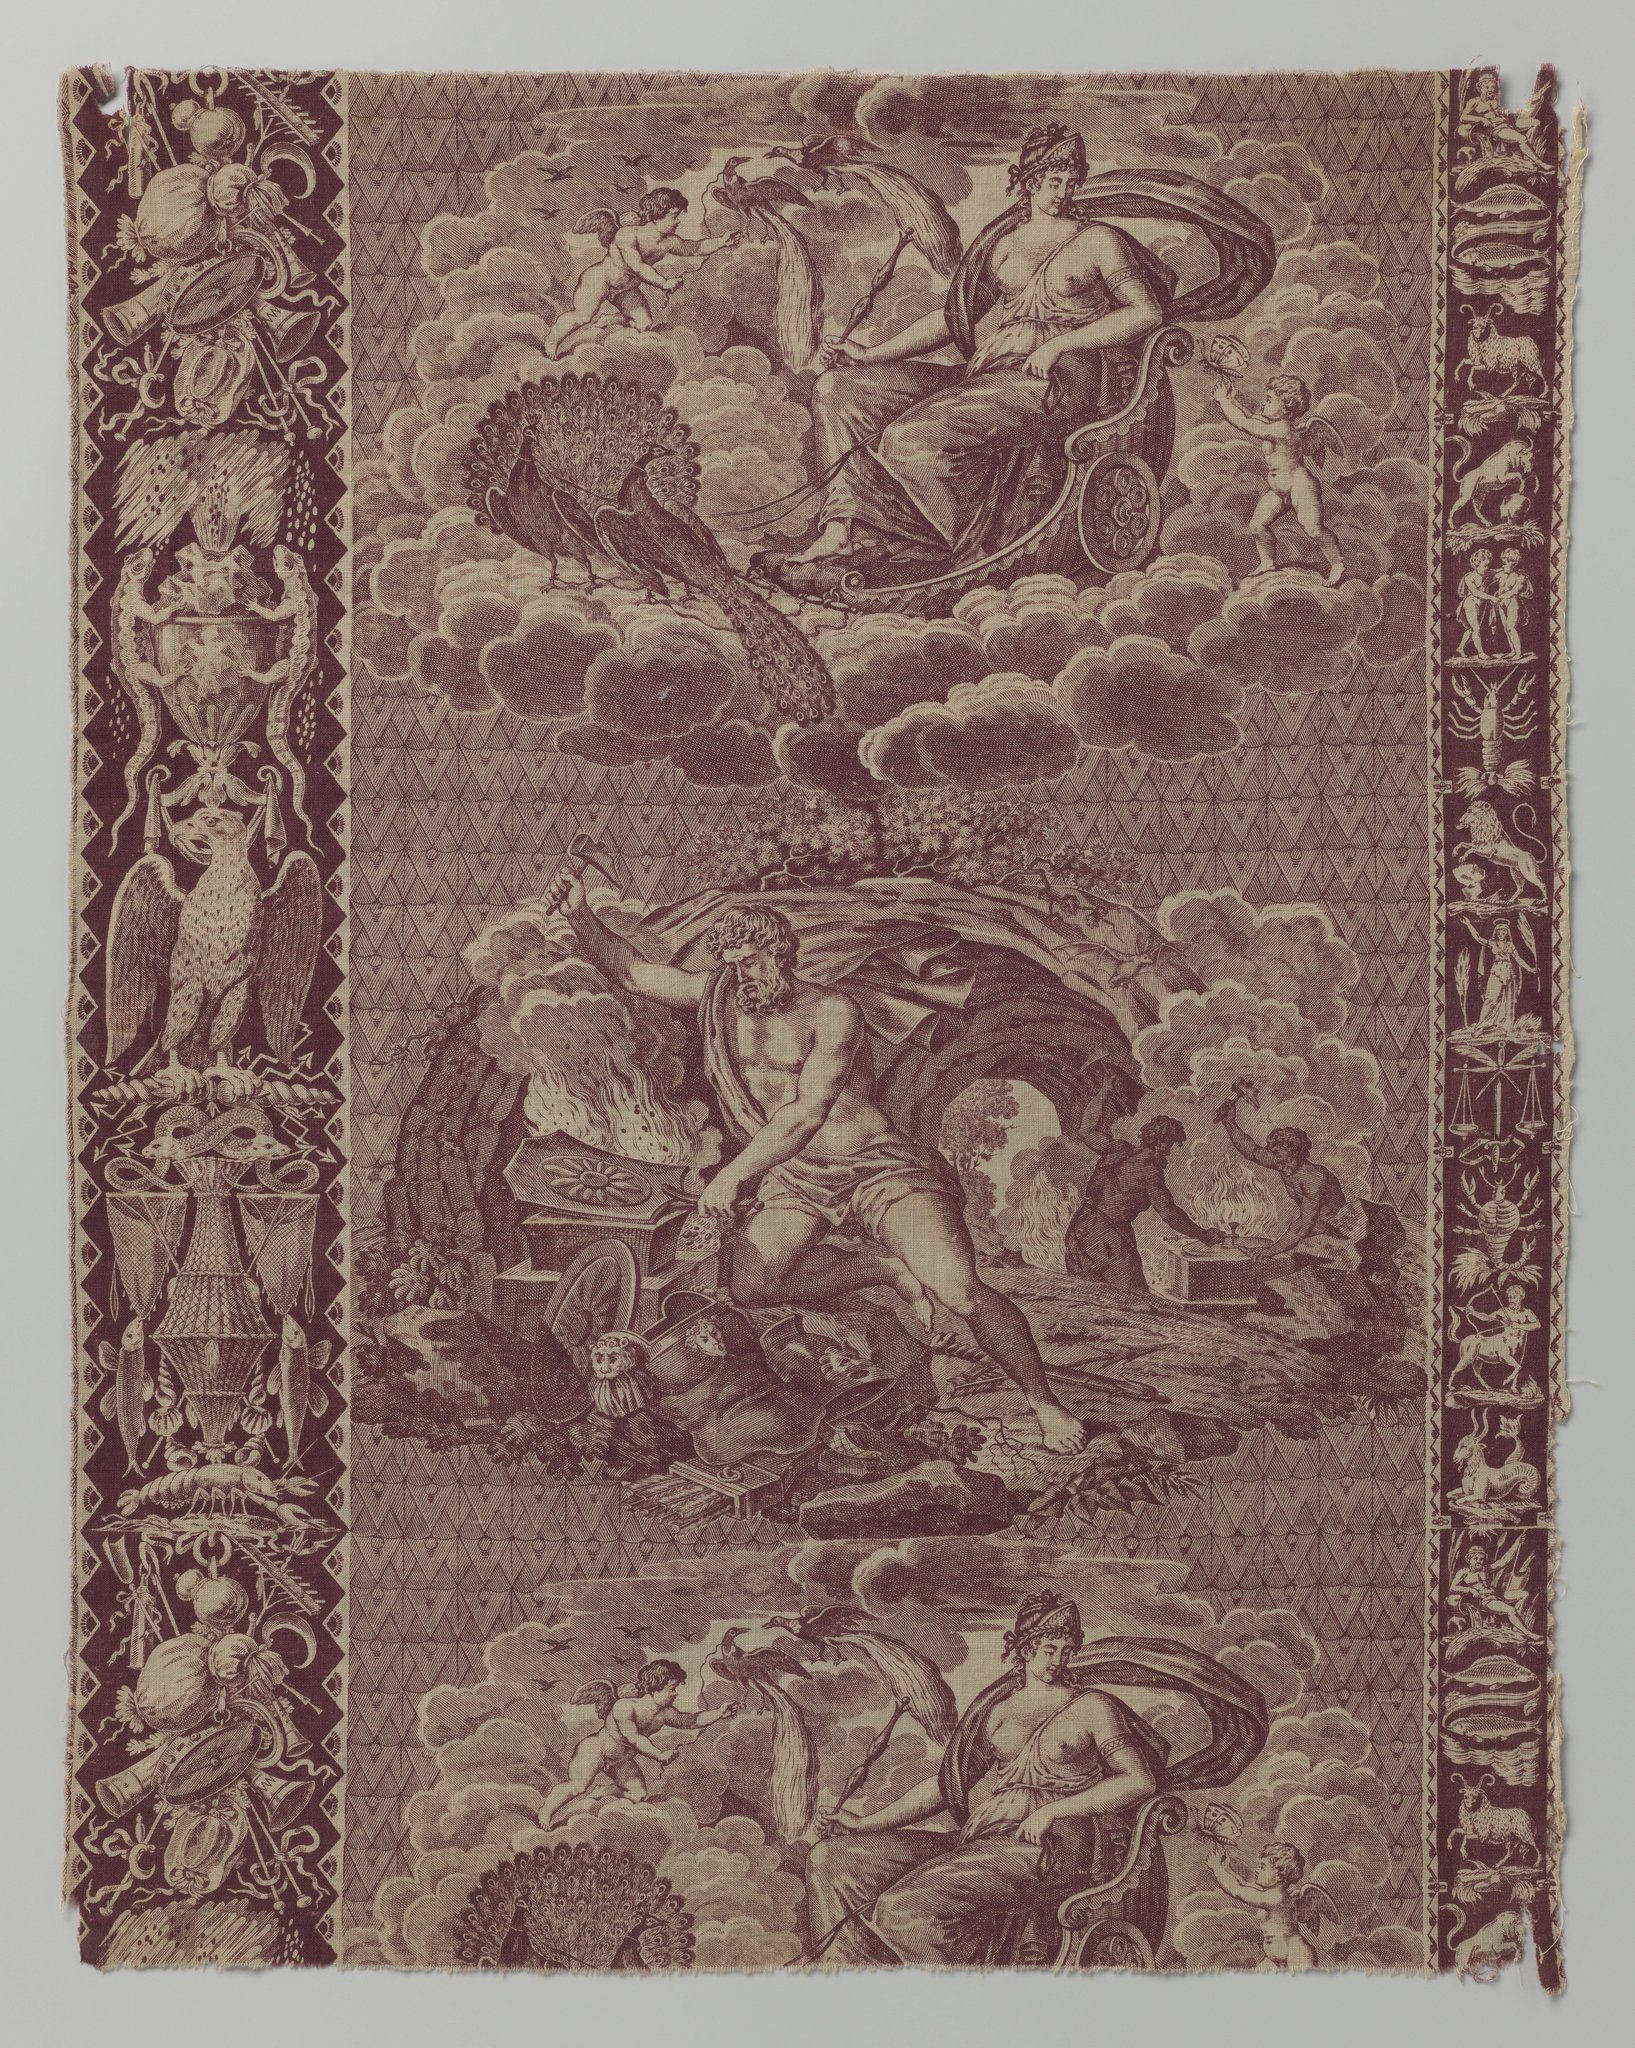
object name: fragment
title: Fragment bedrukte katoen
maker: Anonymous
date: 1600-1899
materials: cotton, paint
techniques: printing, weave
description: Fragment bedrukte katoen met Romeins aandoende afbeeldingen en aan de zijkanten de sterrenbeelden afgebeeld